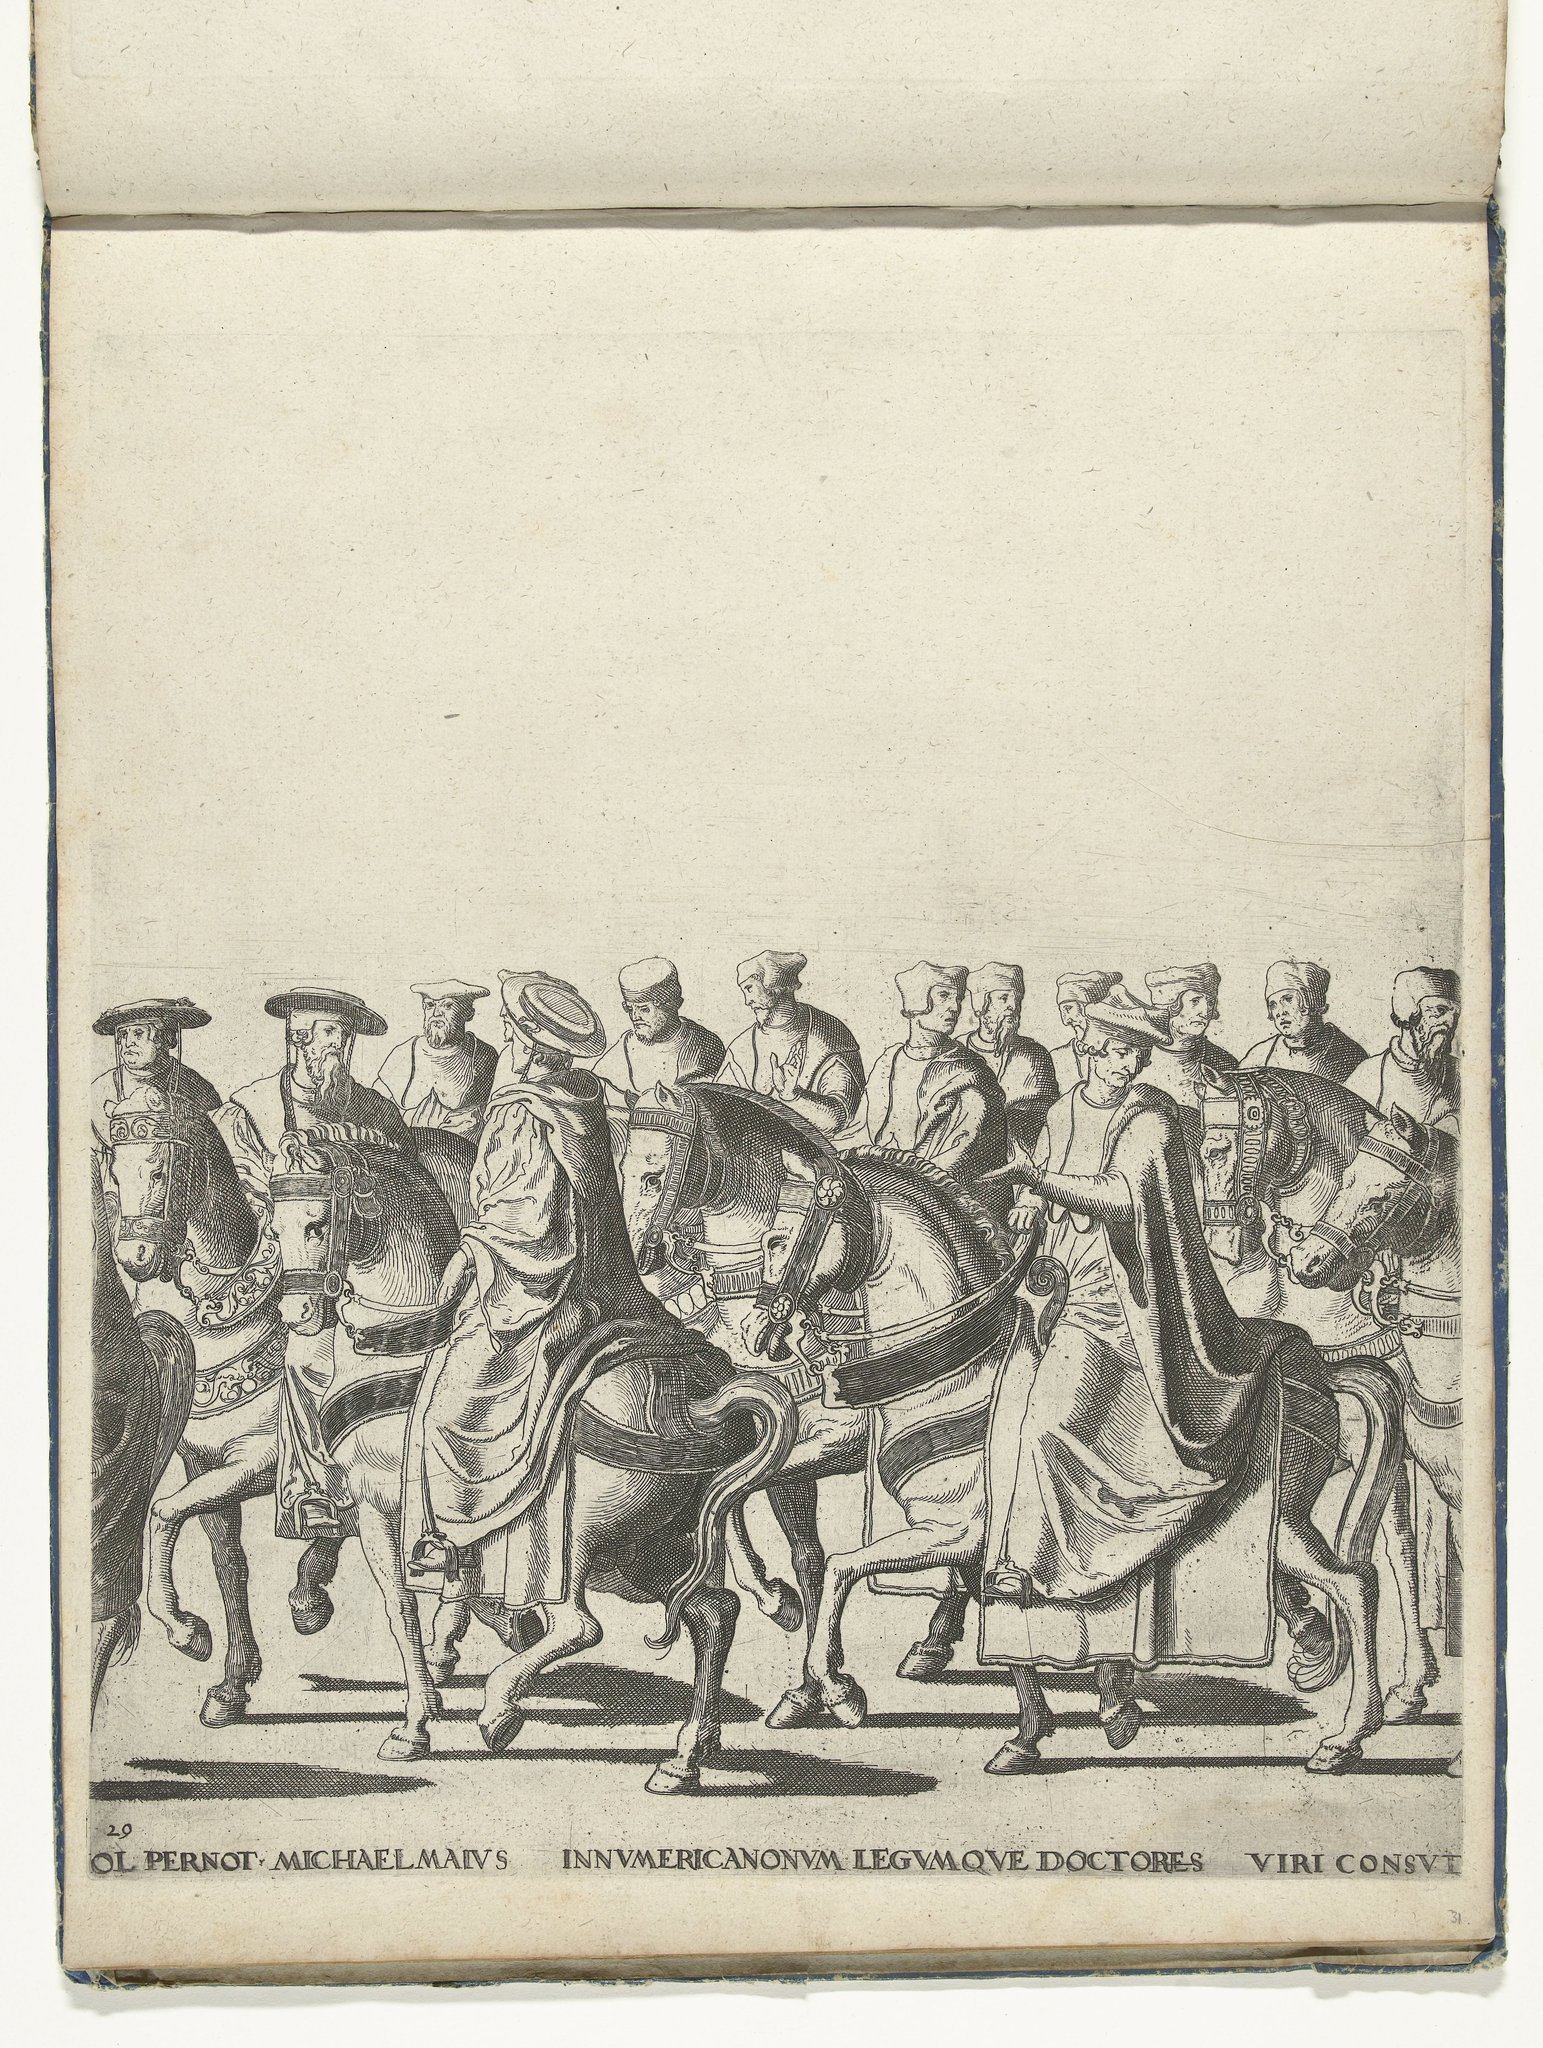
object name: propagandaprent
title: Kerkgeleerden waaronder Nicolas Perrenot de Granvelle en Michele Maio, plaat 29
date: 1530-1536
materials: paper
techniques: engraving, etching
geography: the hague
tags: nicolas perrenot de granvelle, ghent, charles v (holy roman emperor and king of spain), festivities (+ parade, pageant, cavalcade ~ festive activities)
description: Prent in het album waarin zijn ingeplakt de 40 platen die achterelkaar samen het fries vormen van de optocht van Karel V met de paus Clemens VII te Bologna na zijn kroning tot keizer, 24 februari 1530.